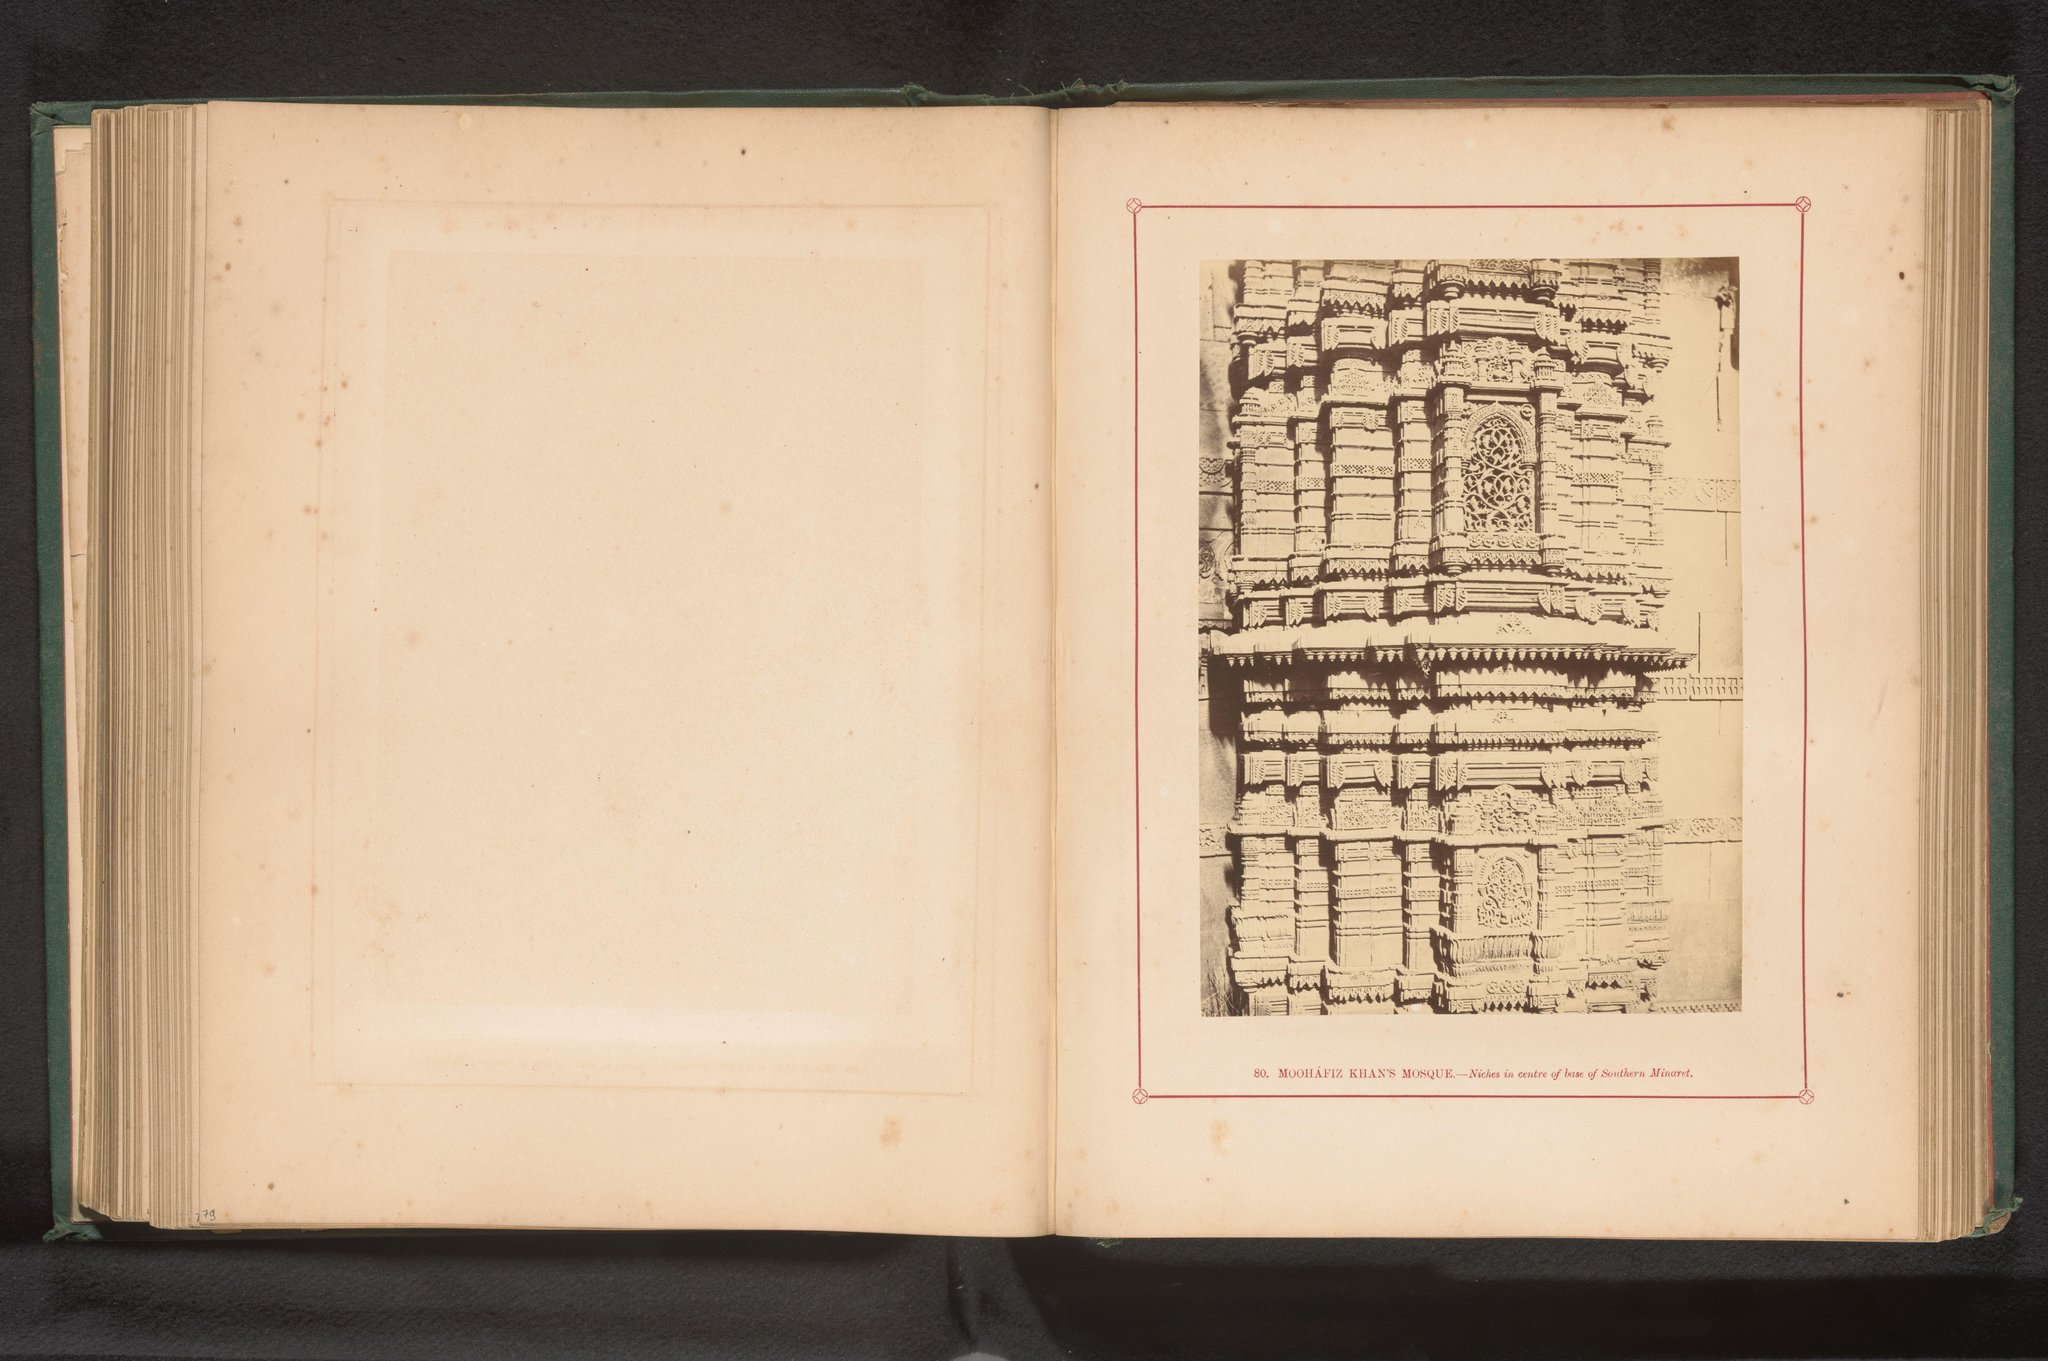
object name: photograph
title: Decoratie van het basement van een minaret van de Muhafiz Khan-moskee in Ahmedabad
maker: thomas biggs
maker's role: fotograaf, kapitein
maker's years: 1822-1905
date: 1856-1866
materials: photographic support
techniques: albumen print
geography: ahmedabad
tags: temple, shrine ~ islam, mohammedanism, base (~ column, pillar)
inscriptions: number: ‘80.’